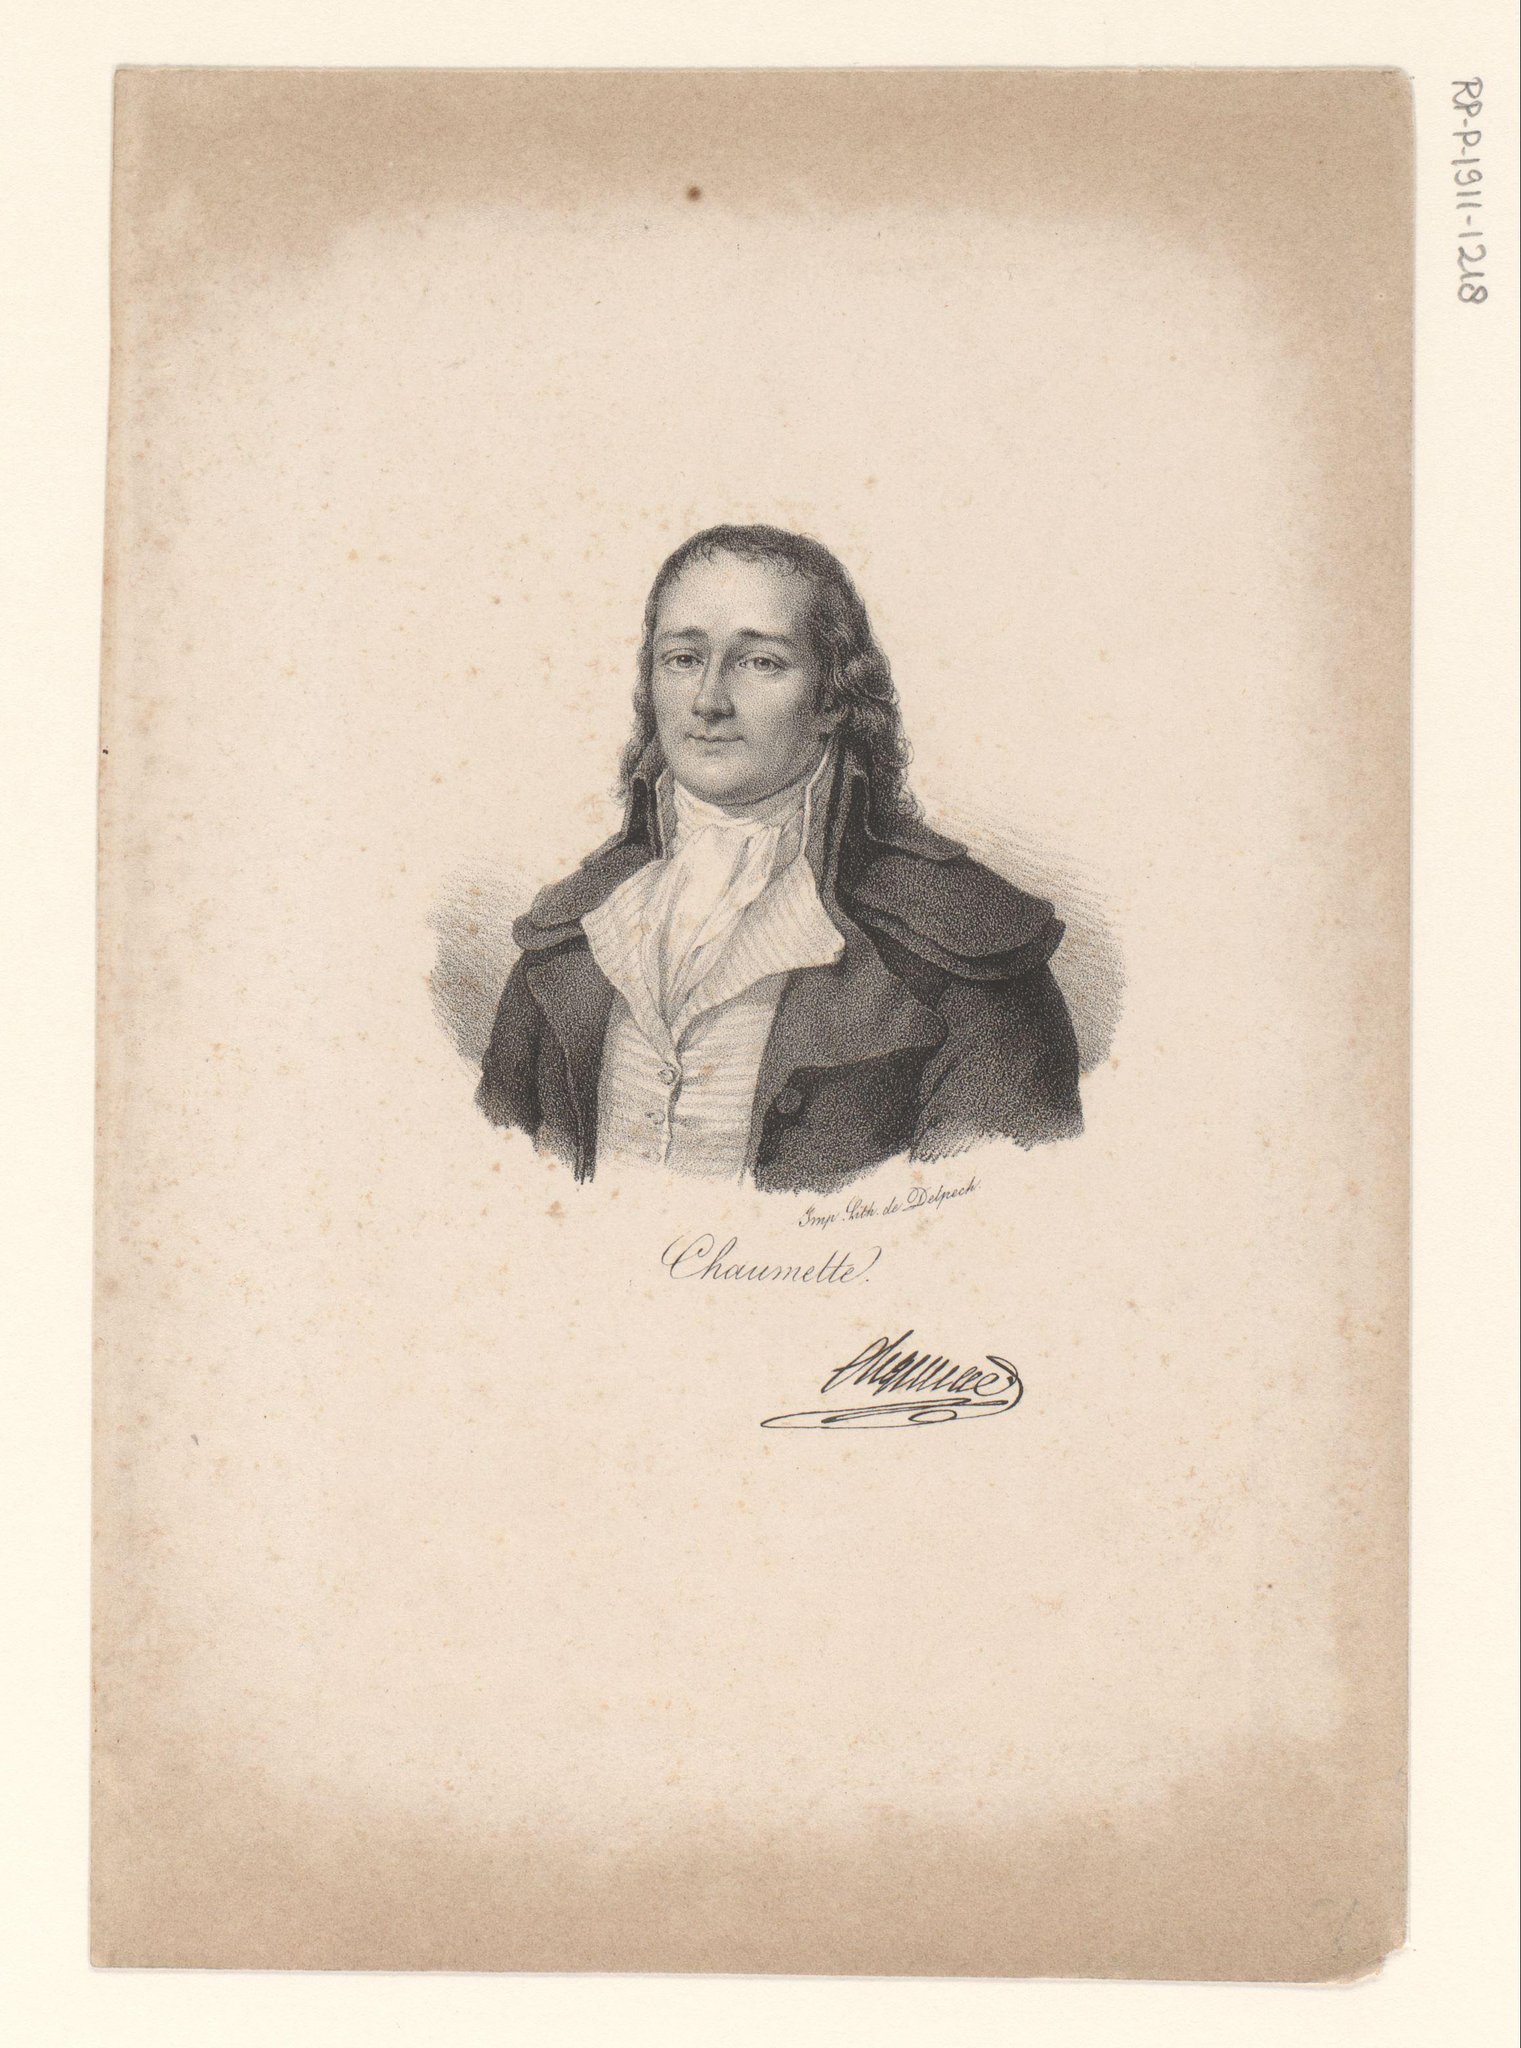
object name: print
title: Chaumette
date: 1818-1842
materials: paper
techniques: lithograph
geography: paris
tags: historical persons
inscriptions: collector's mark: Lugt 2228a